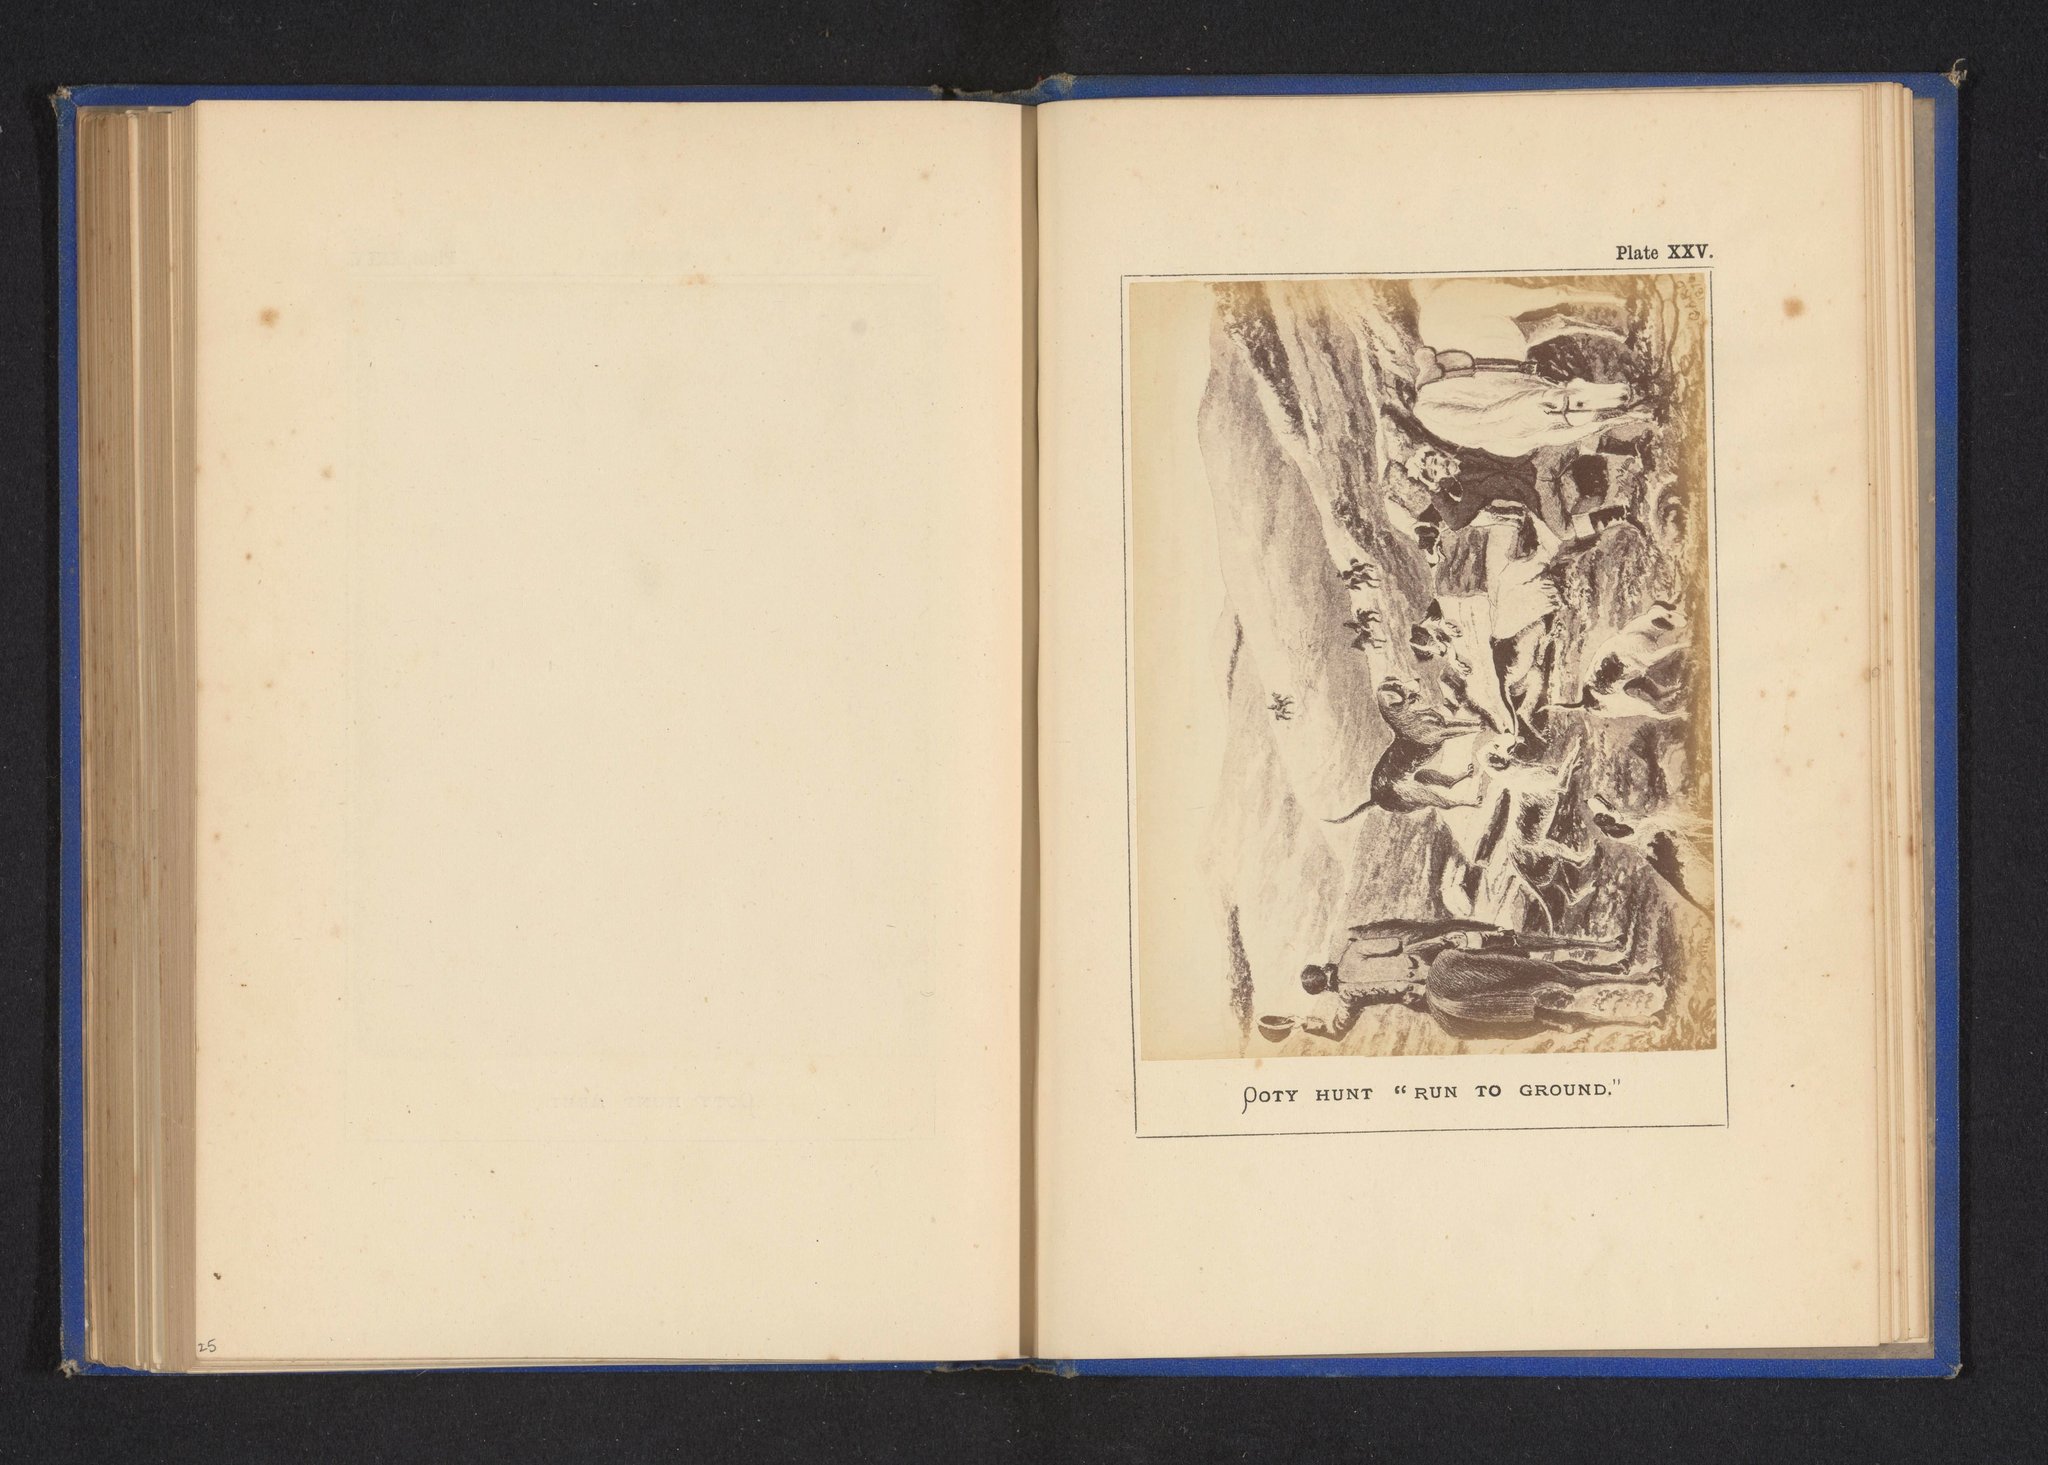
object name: page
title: Fotoreproductie van een tekening van jagers en jachthonden in Udhagamandalam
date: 1870-1880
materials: photographic support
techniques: albumen print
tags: drawing, sketch, hunt ~ mammals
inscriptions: number: ‘Plate XXV.’